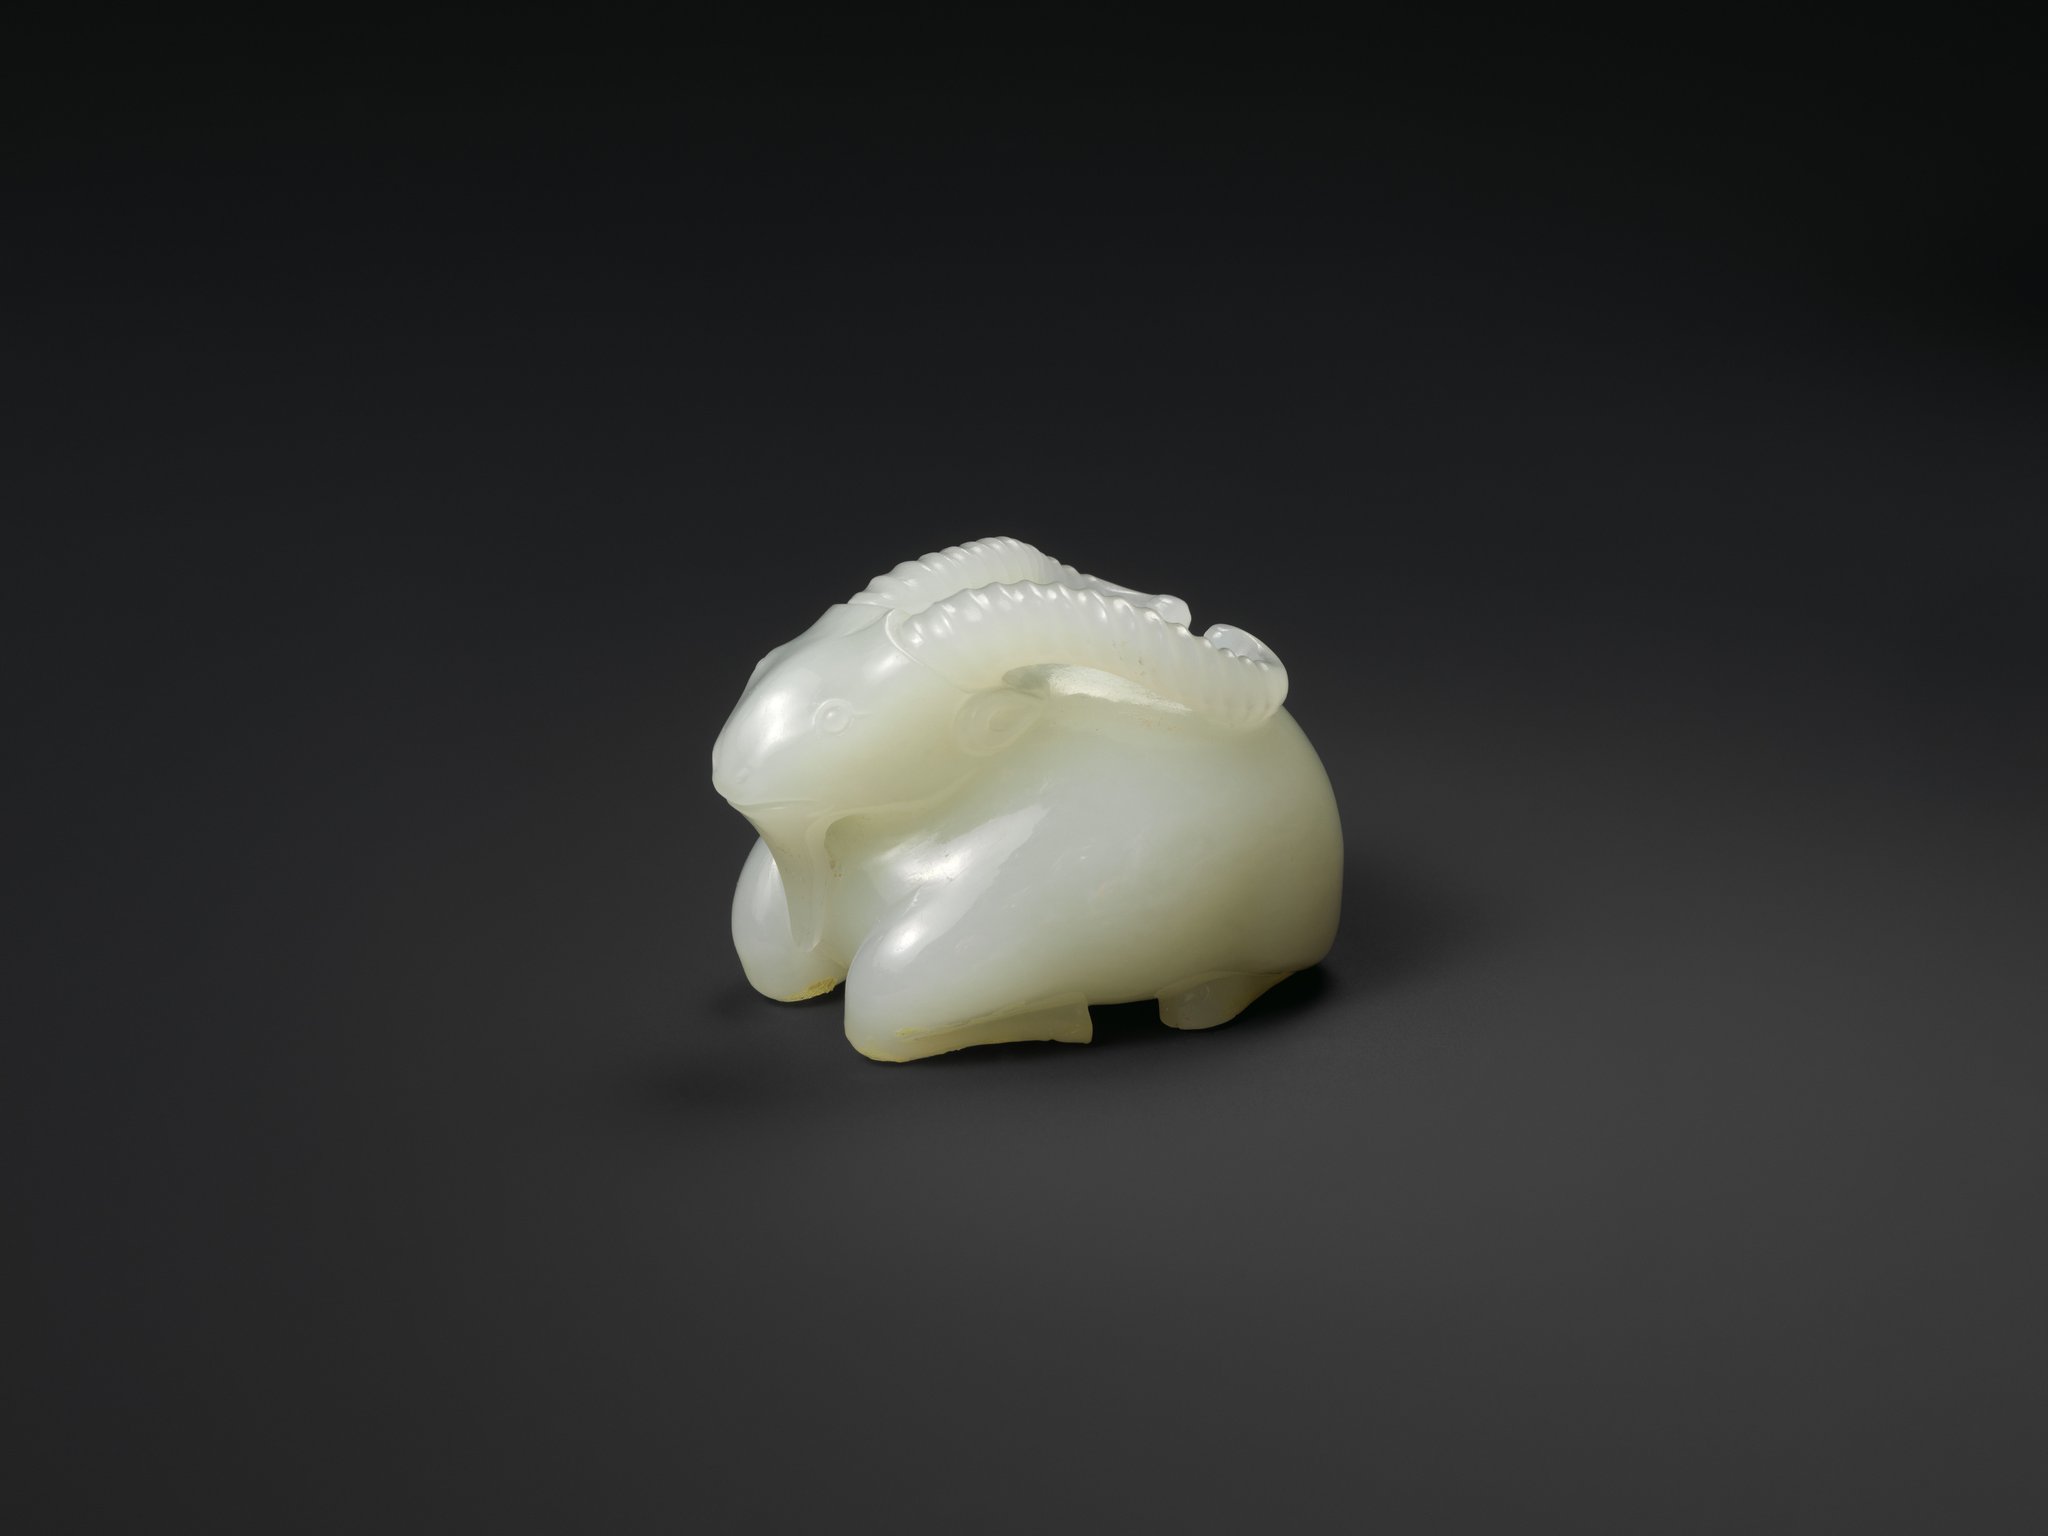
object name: figurine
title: Ram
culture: chinese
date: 1767-1833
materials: jade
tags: rams